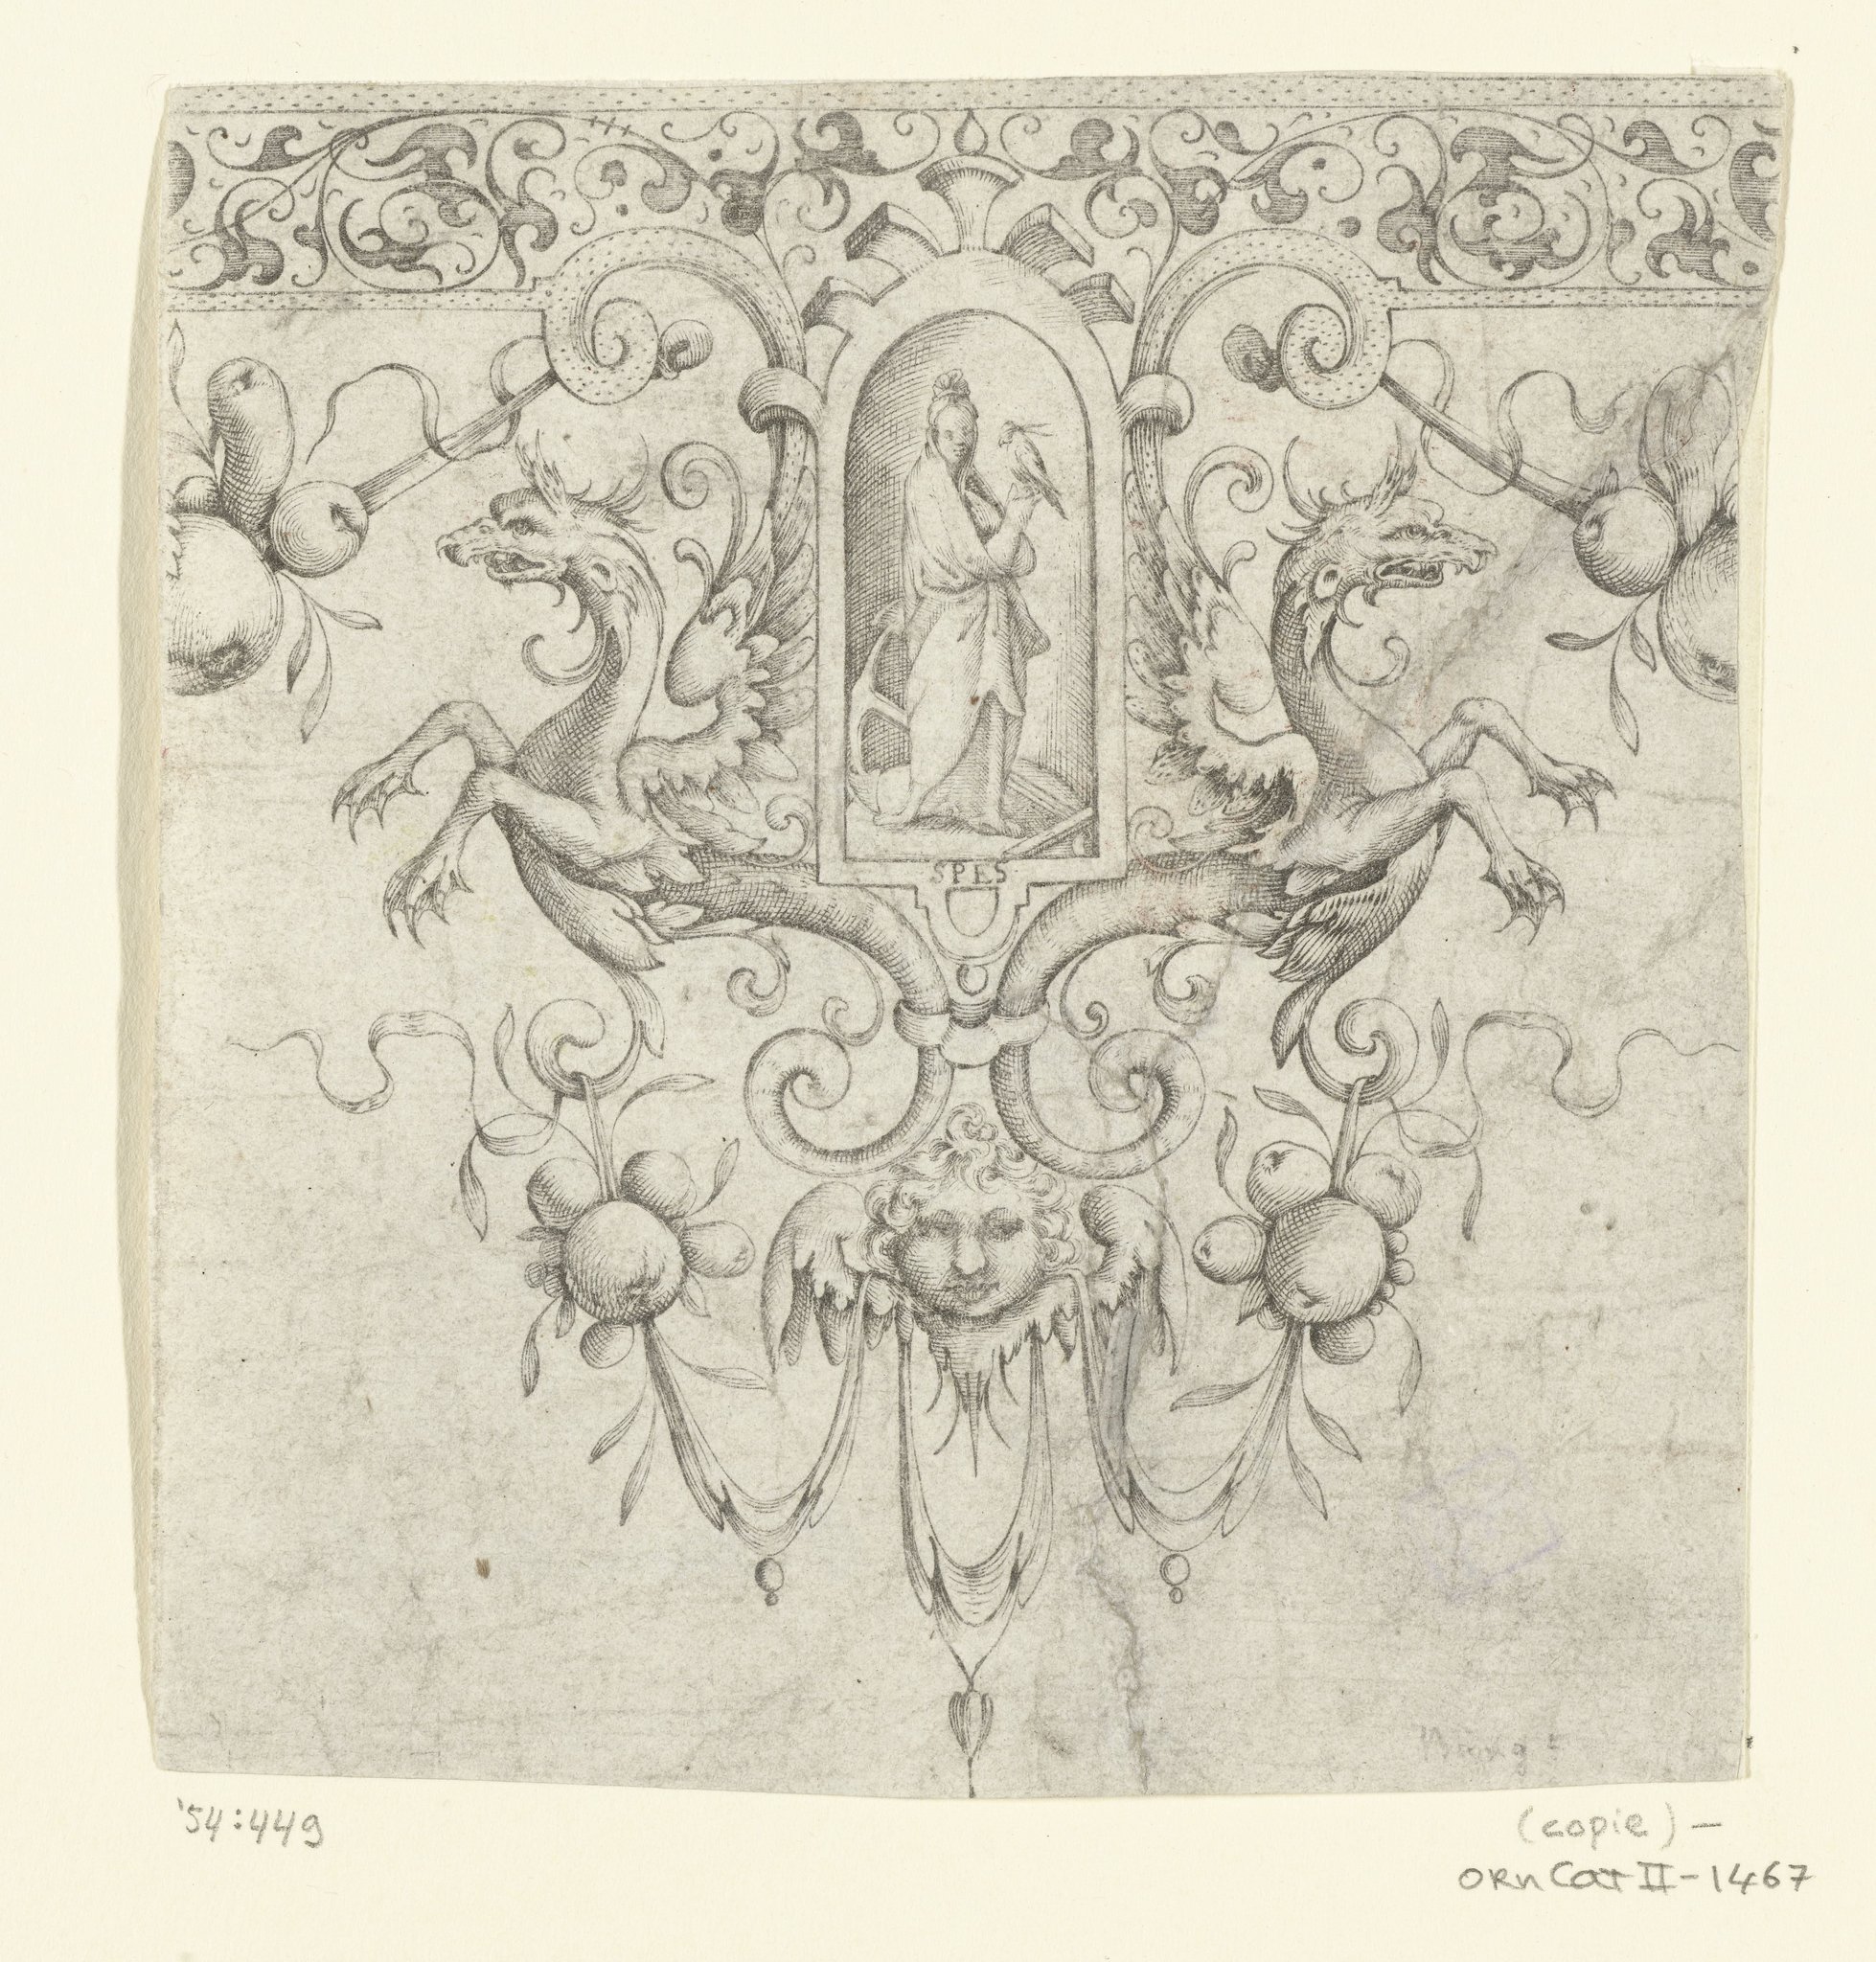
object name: print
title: Spitsen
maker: Anonymous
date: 1615-1700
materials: paper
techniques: engraving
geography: amsterdam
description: Tegenzijdige kopie van prent met objectnummer RP-P-1898-A-20102.